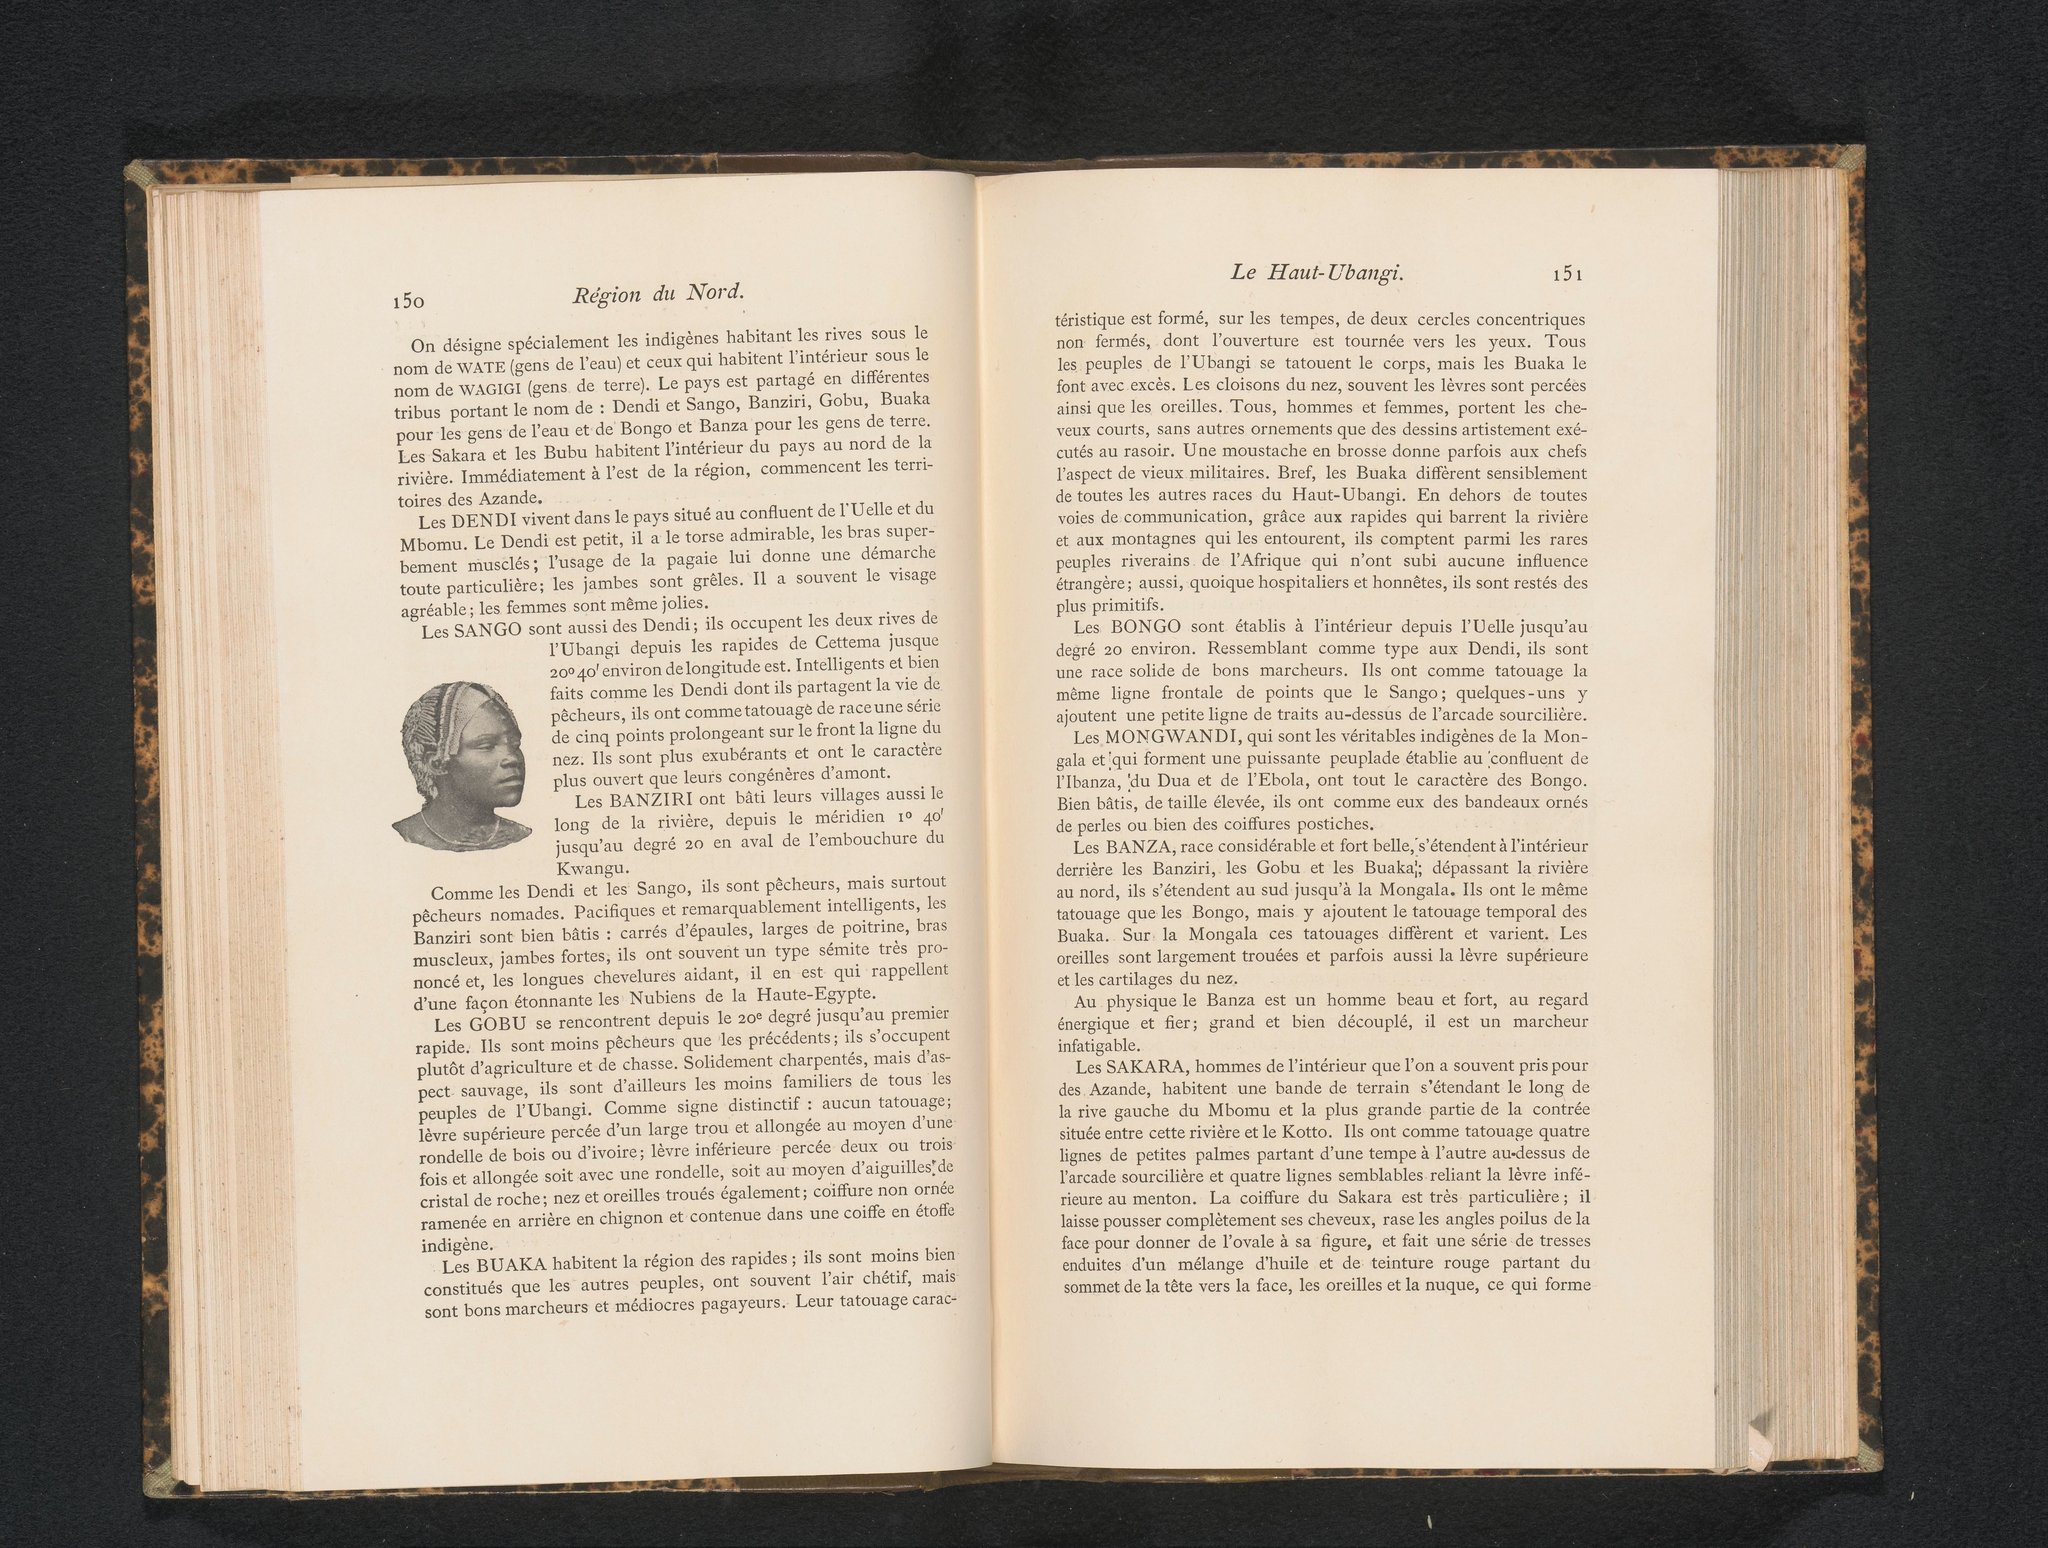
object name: page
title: Portret van een onbekende vrouw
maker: Anonymous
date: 1887-1892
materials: paper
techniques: autotype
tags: historical persons - bb - woman